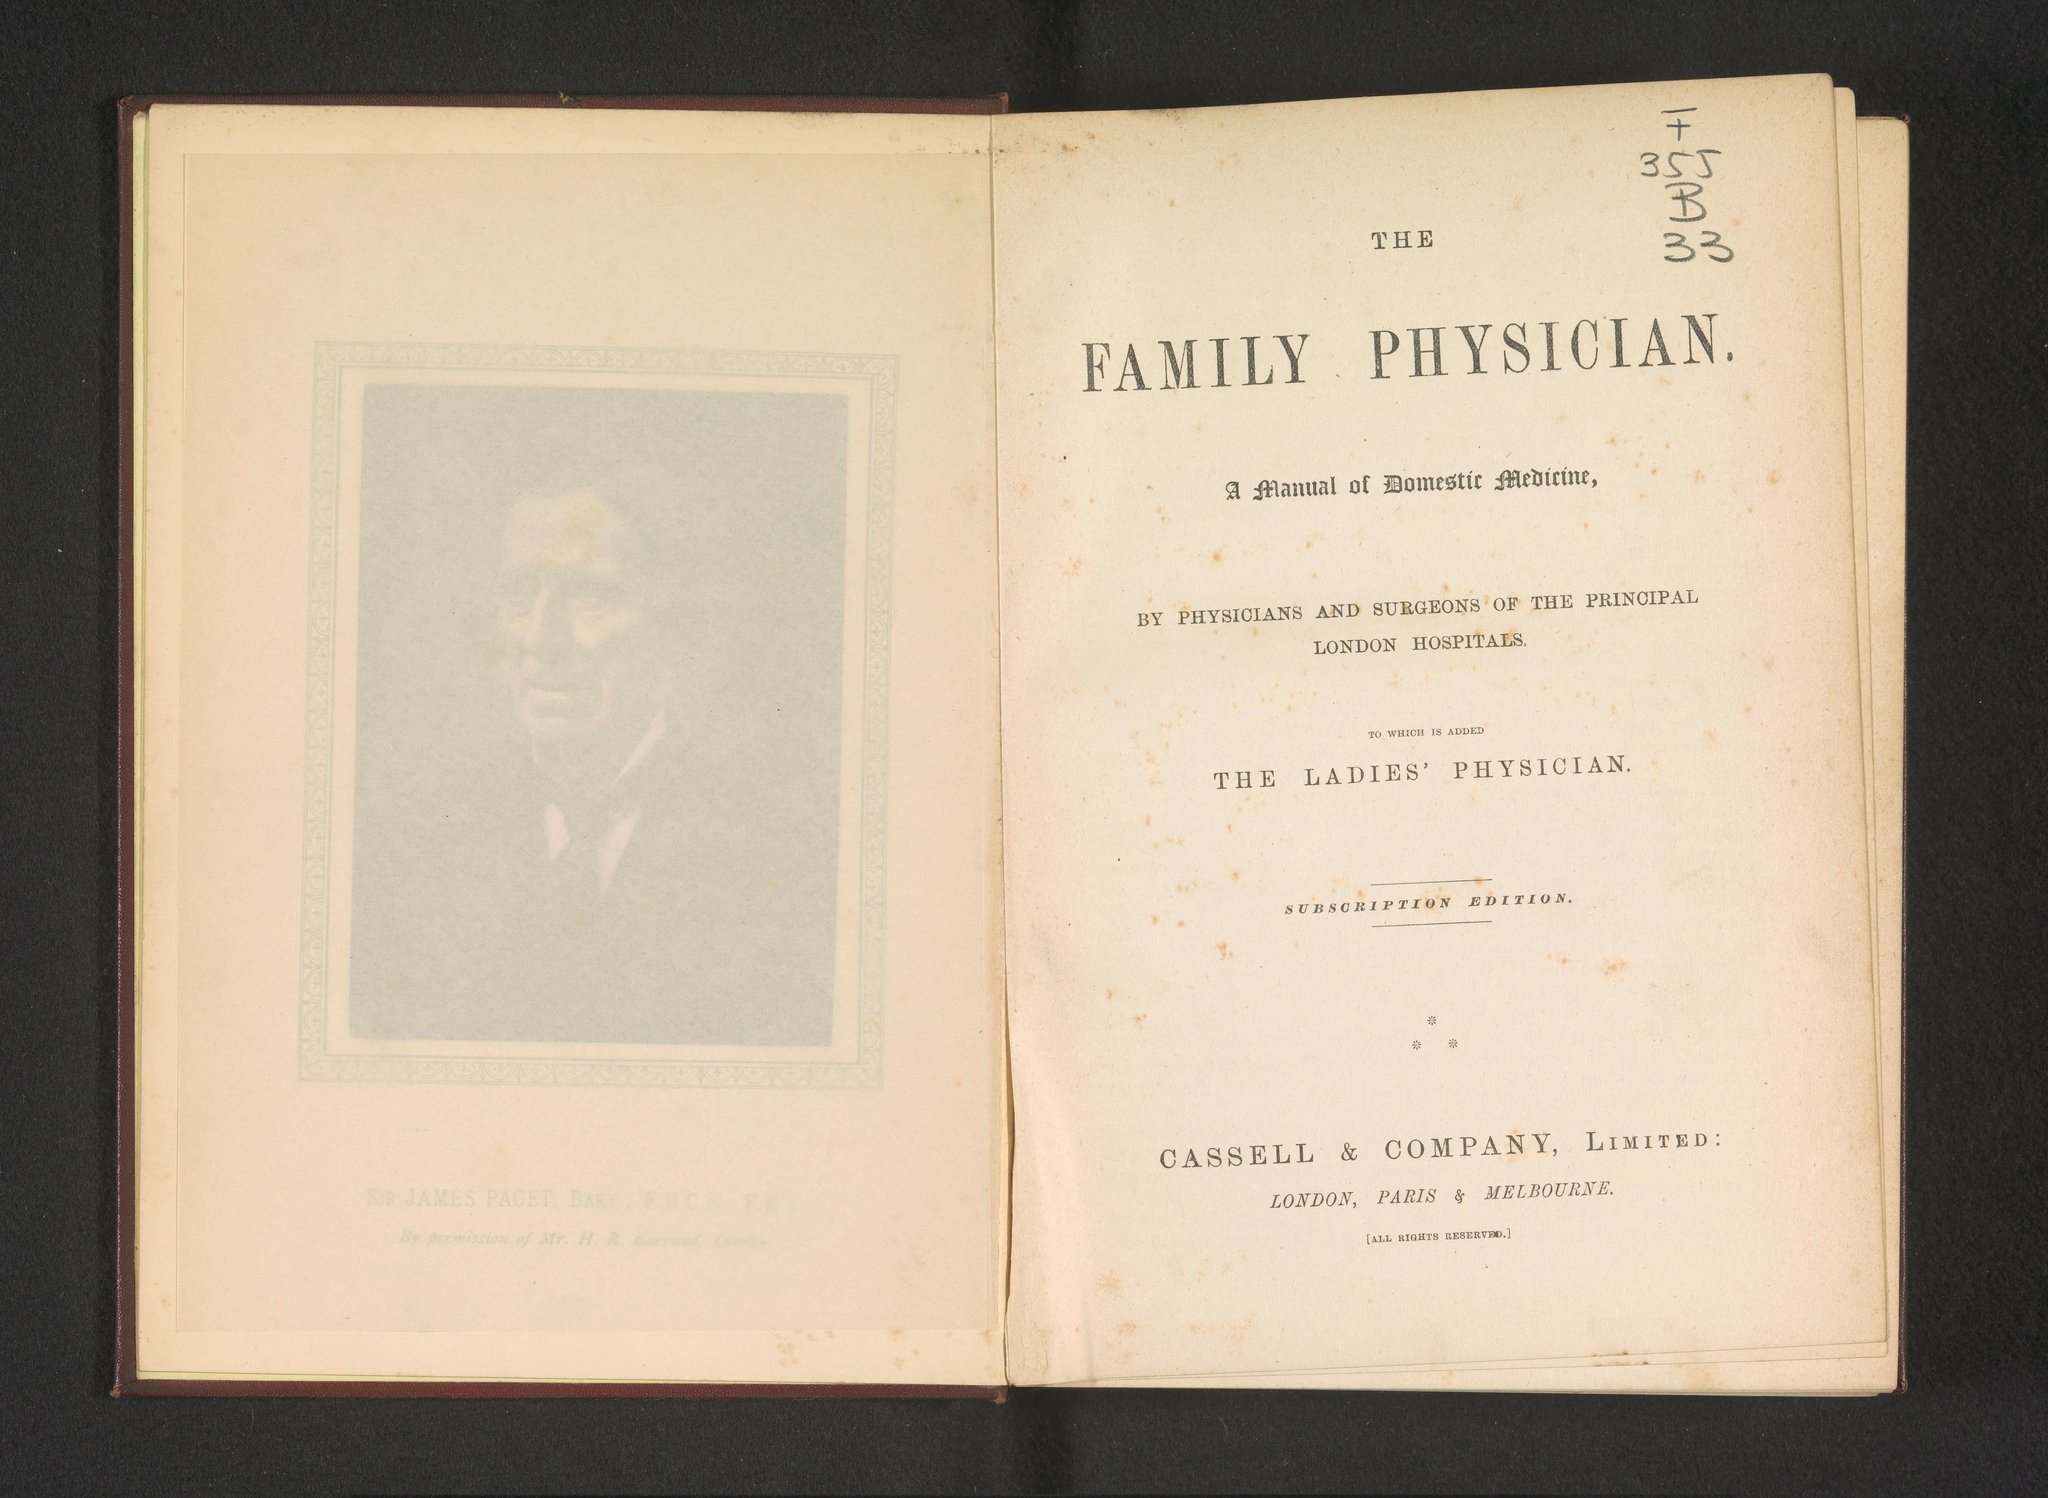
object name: book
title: The family physician volume III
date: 1890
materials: linen, paper, wood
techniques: lithograph, printing, woodburytype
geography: london